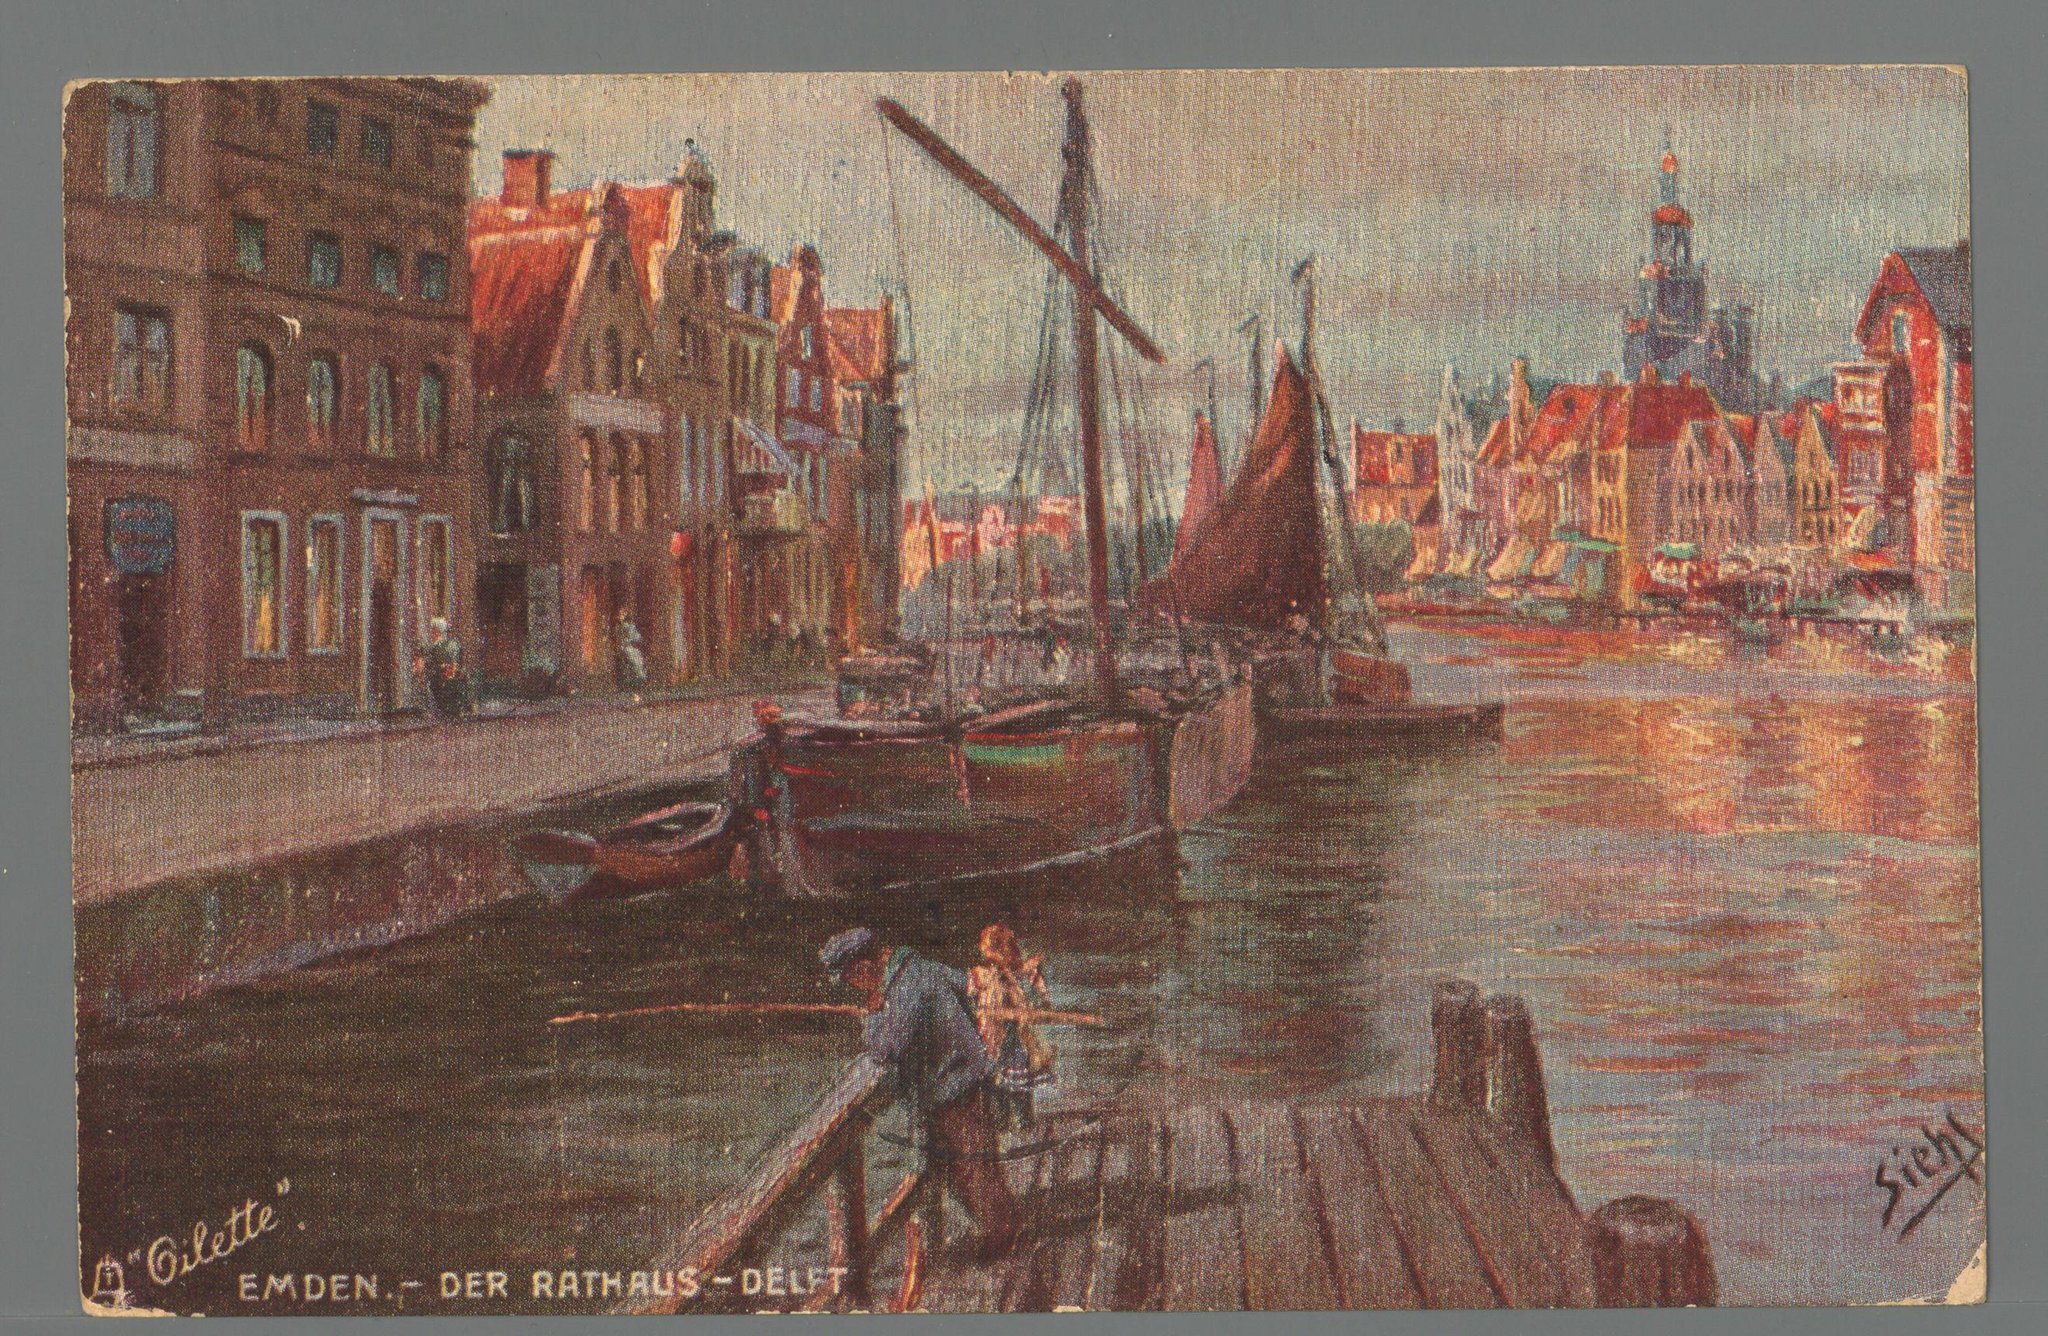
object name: ansichtkaart, prentbriefkaart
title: Oilette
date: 1905-1907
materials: cardboard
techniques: writing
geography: berlin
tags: canals, waters (in village), townhall, street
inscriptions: postage stamp